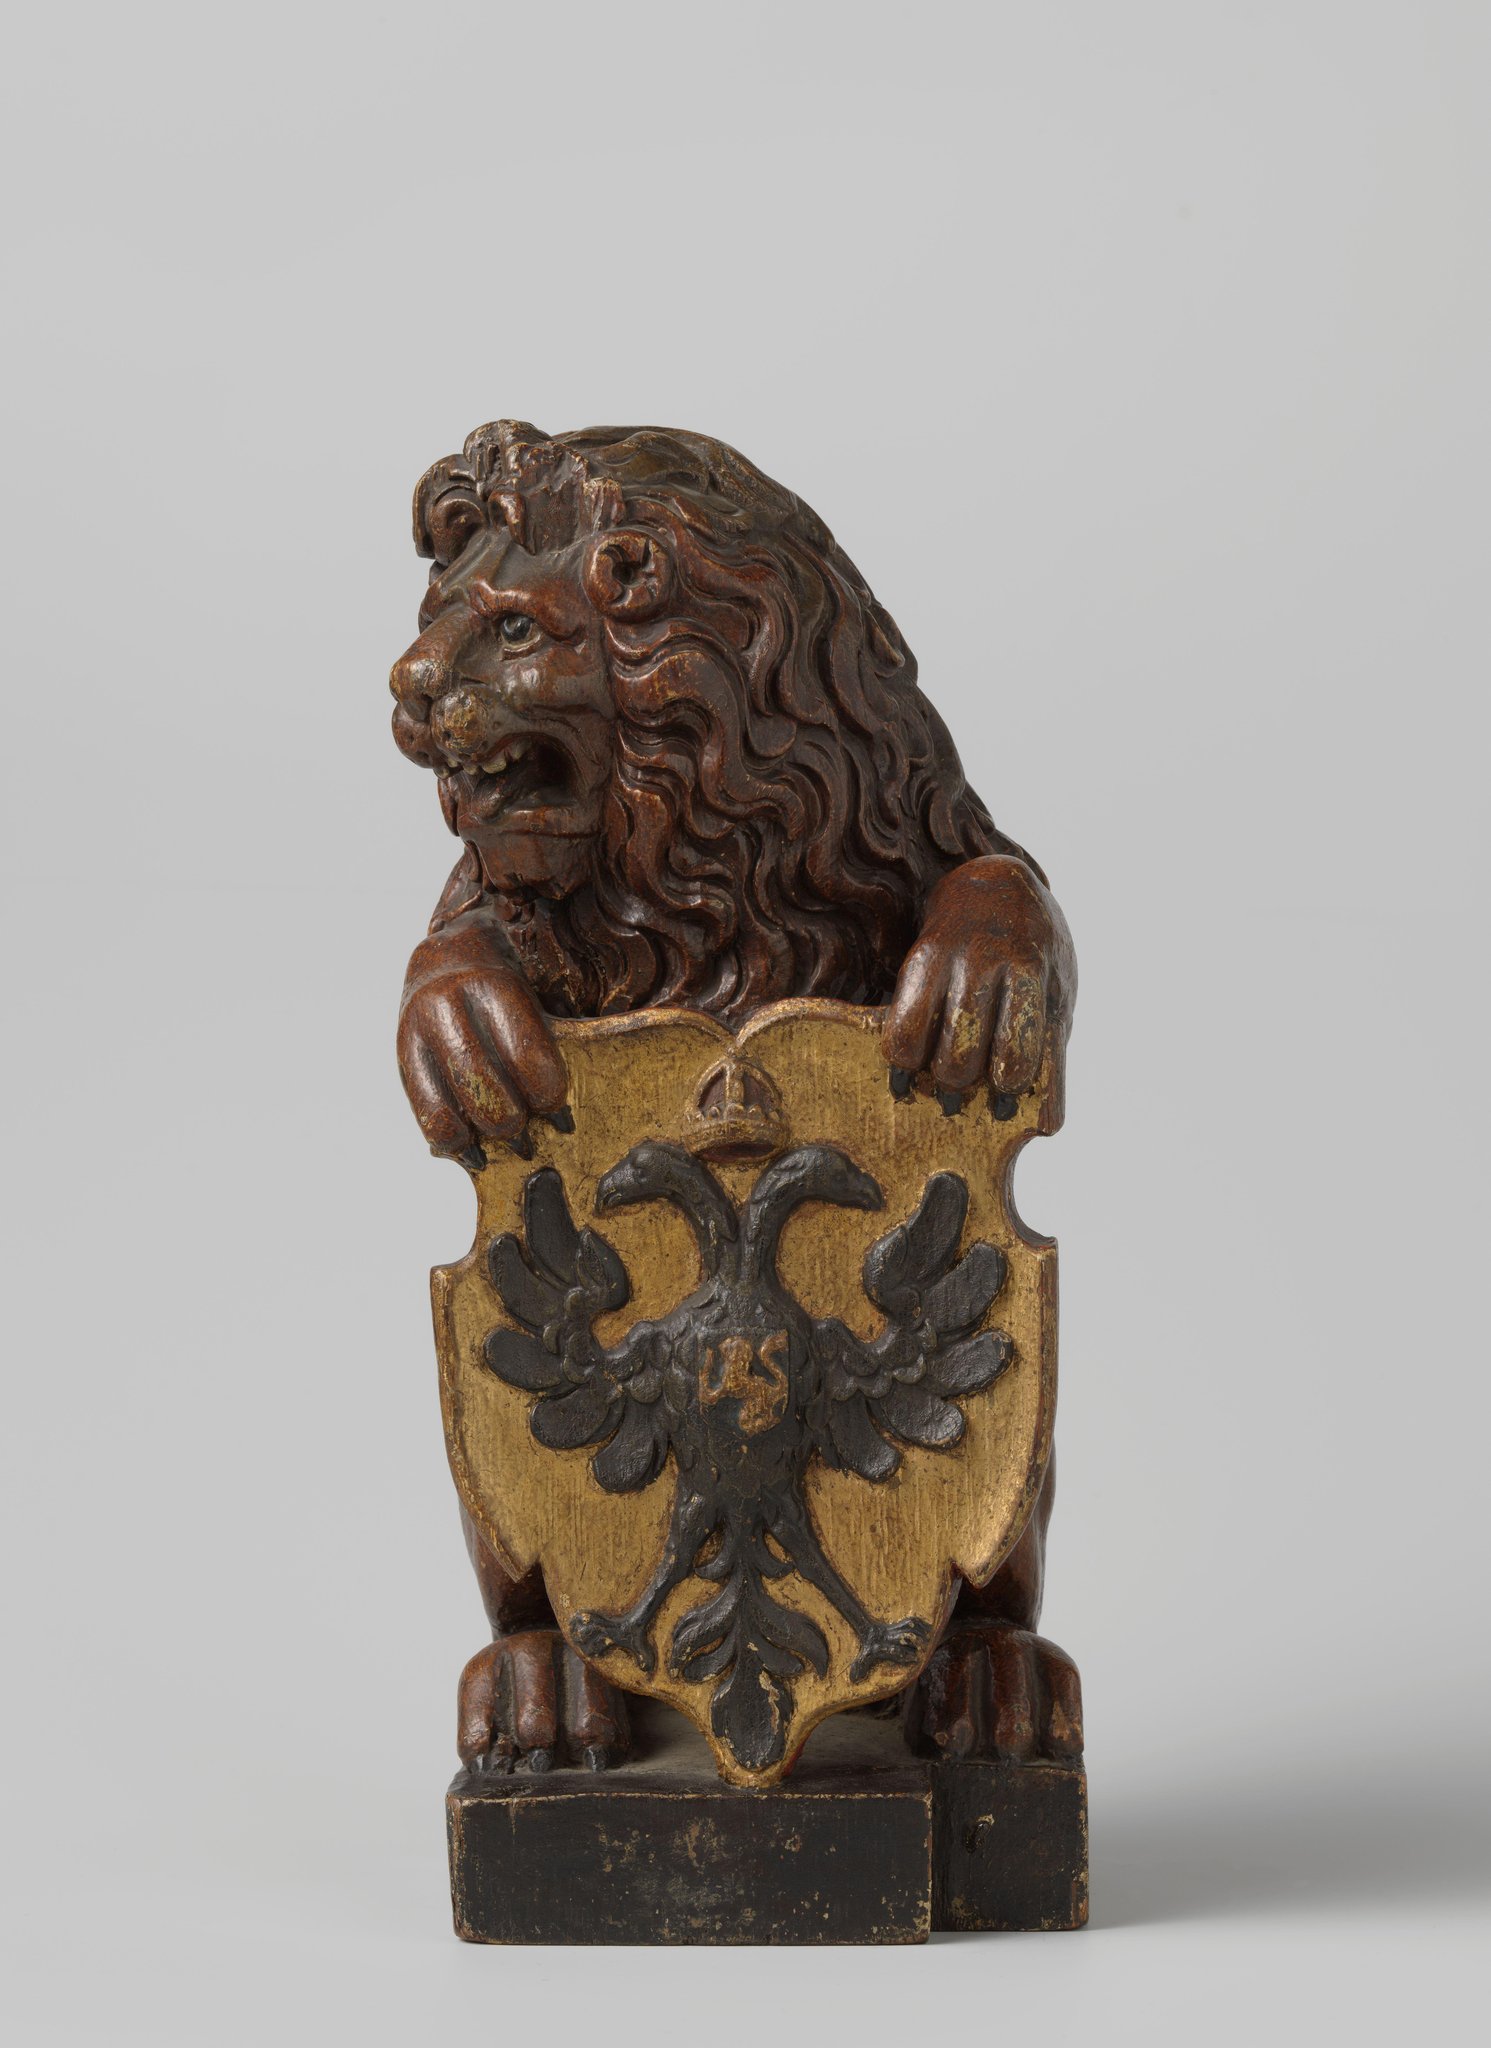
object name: architectural element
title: Schilddrager met een wapenschild met dubbelkoppige adelaar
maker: Anonymous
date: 1600-1699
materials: wood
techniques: painted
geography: northern netherlands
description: Schildhoudende eikenhouten zittende leeuw, geplaatst op een vierkant voetstuk. Het wapenschild vertoont een gekroonde dubbelkoppige adelaar in zwart op een gouden fond; het hartschild vertoont een leeuw in goud op een donker fond. De achterkant van het schild is rood, de leeuw is bruin en het voetstuk is zwart geschilderd. Wapen van Rijnland (?)